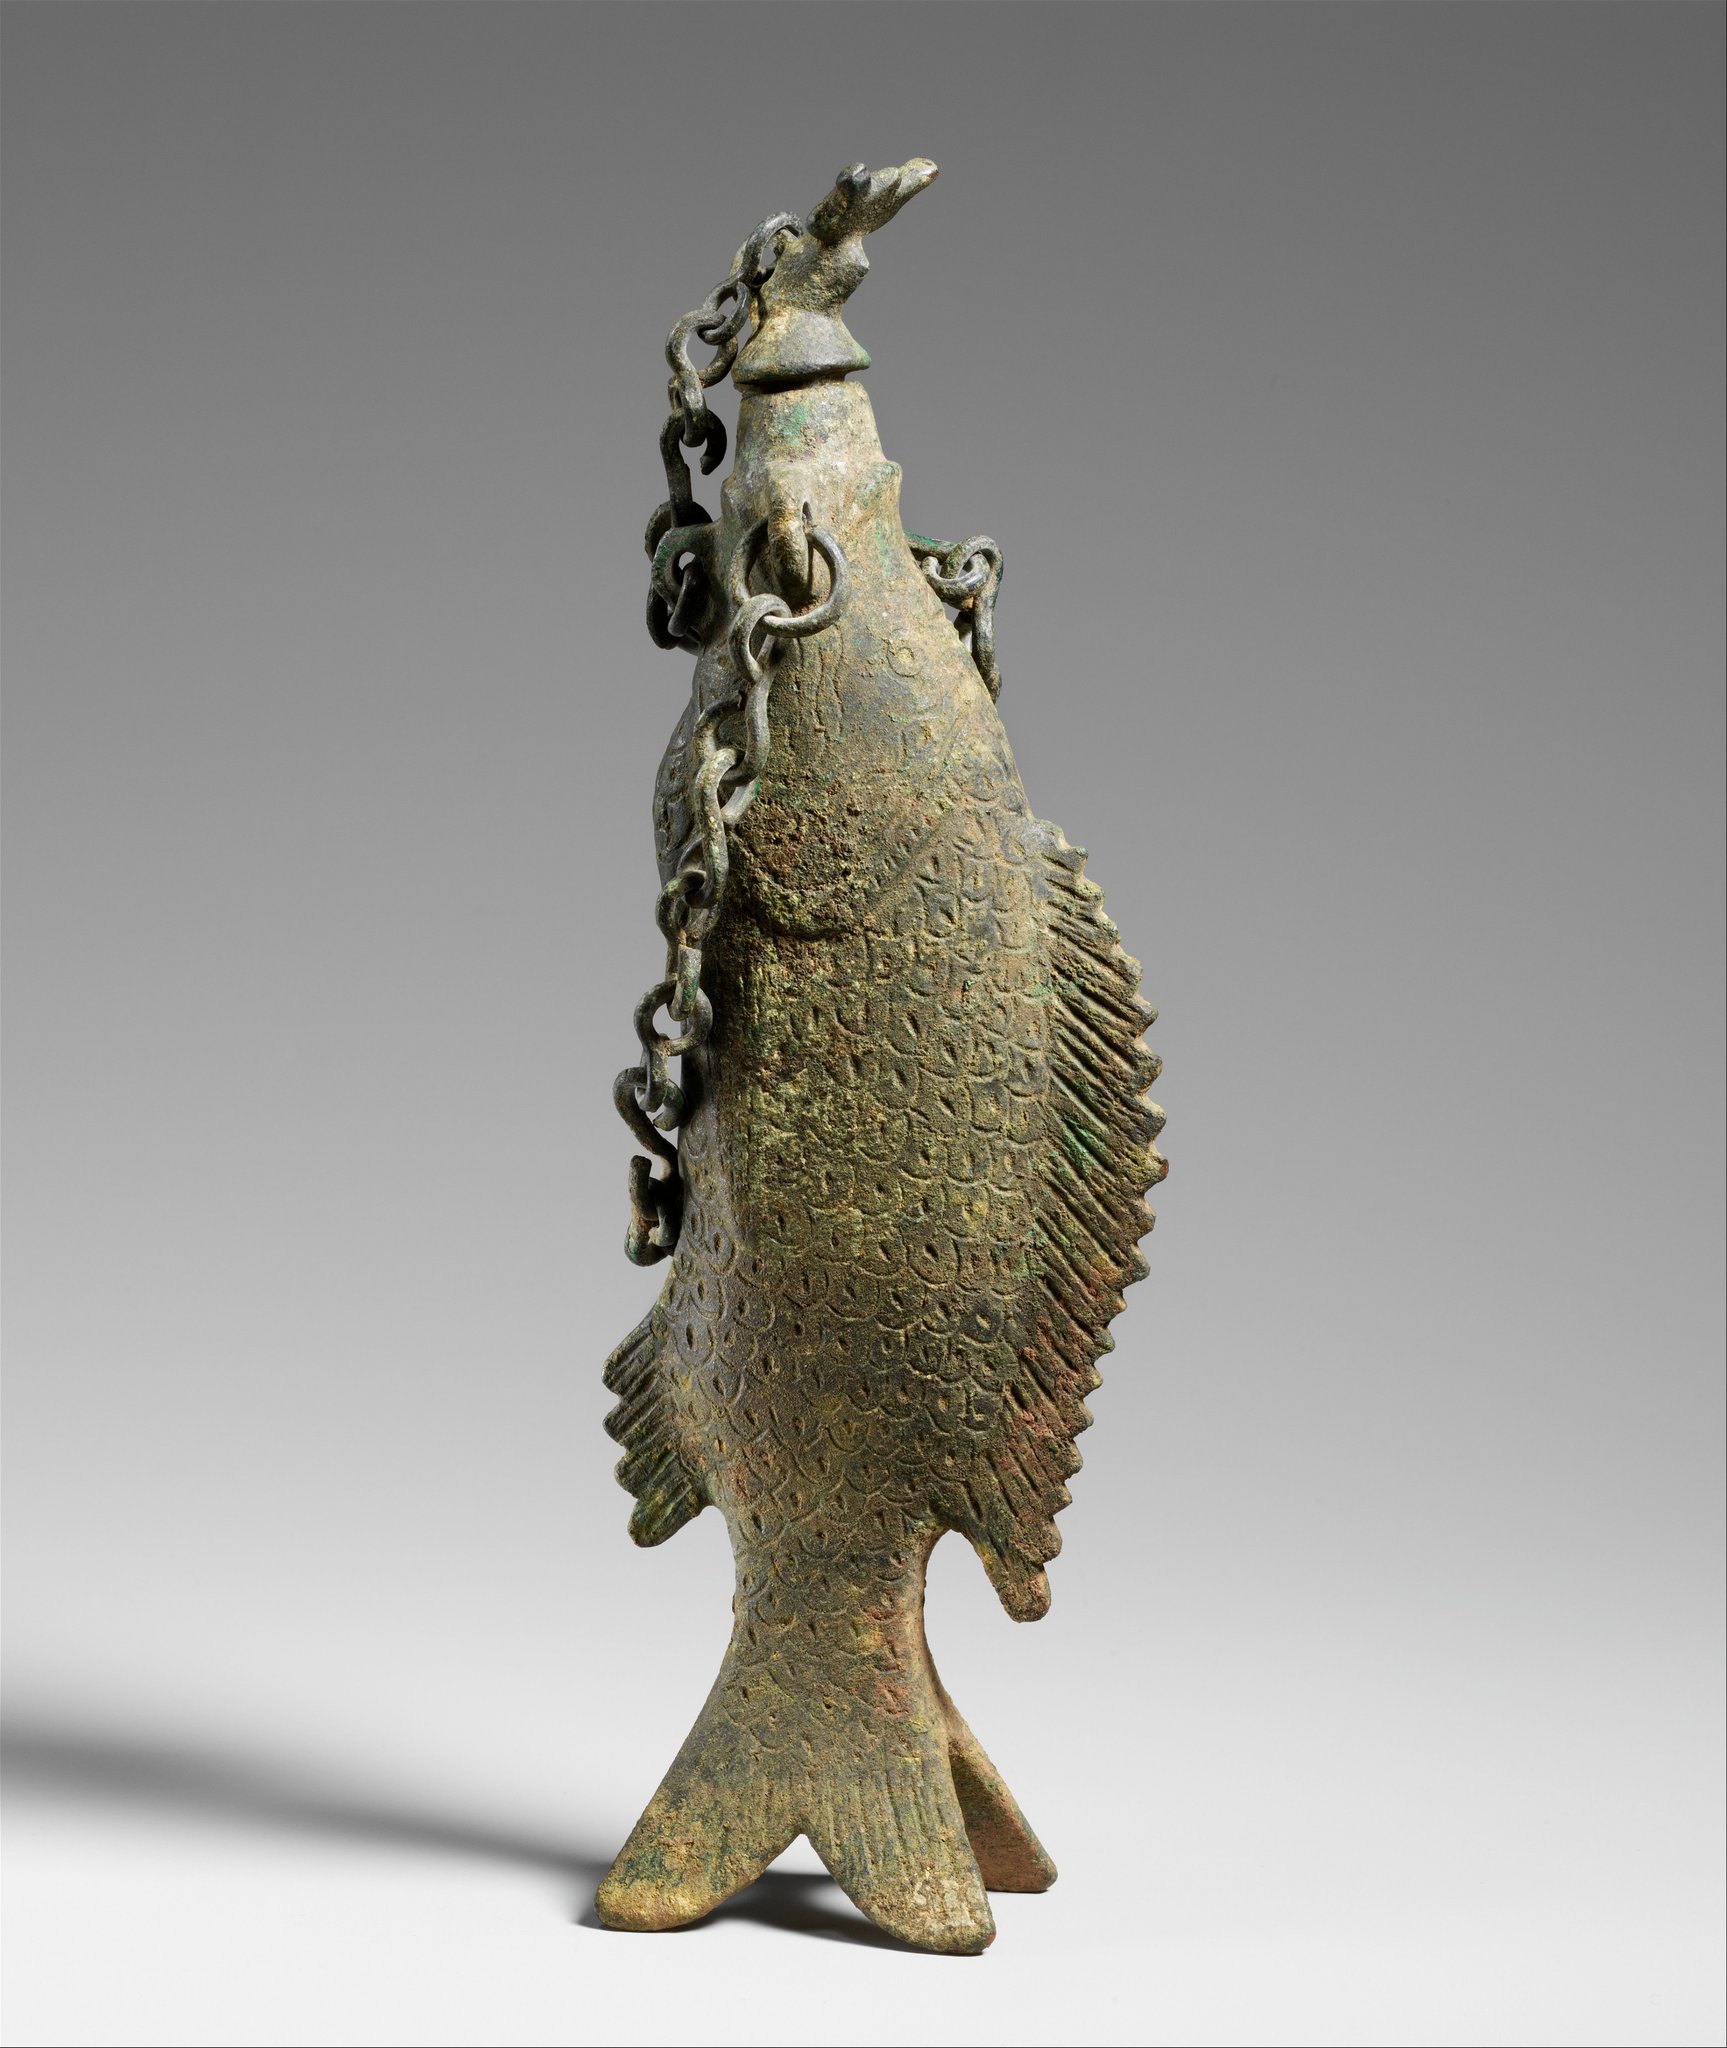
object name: jar, oil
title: Vessel in the Shape of a Fish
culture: byzantine or roman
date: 301-600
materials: copper alloy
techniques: casting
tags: fish